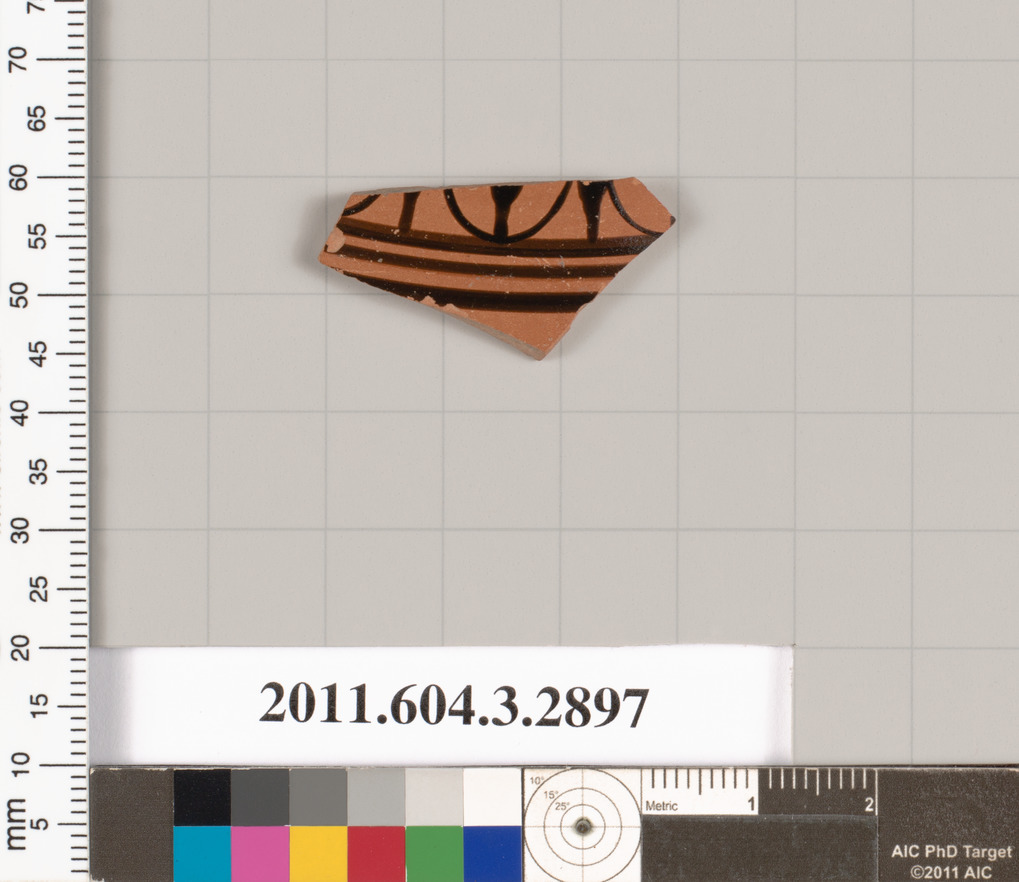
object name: undetermined closed shape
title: Terracotta fragment of a closed shape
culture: greek, attic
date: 525-501 BCE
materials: terracotta